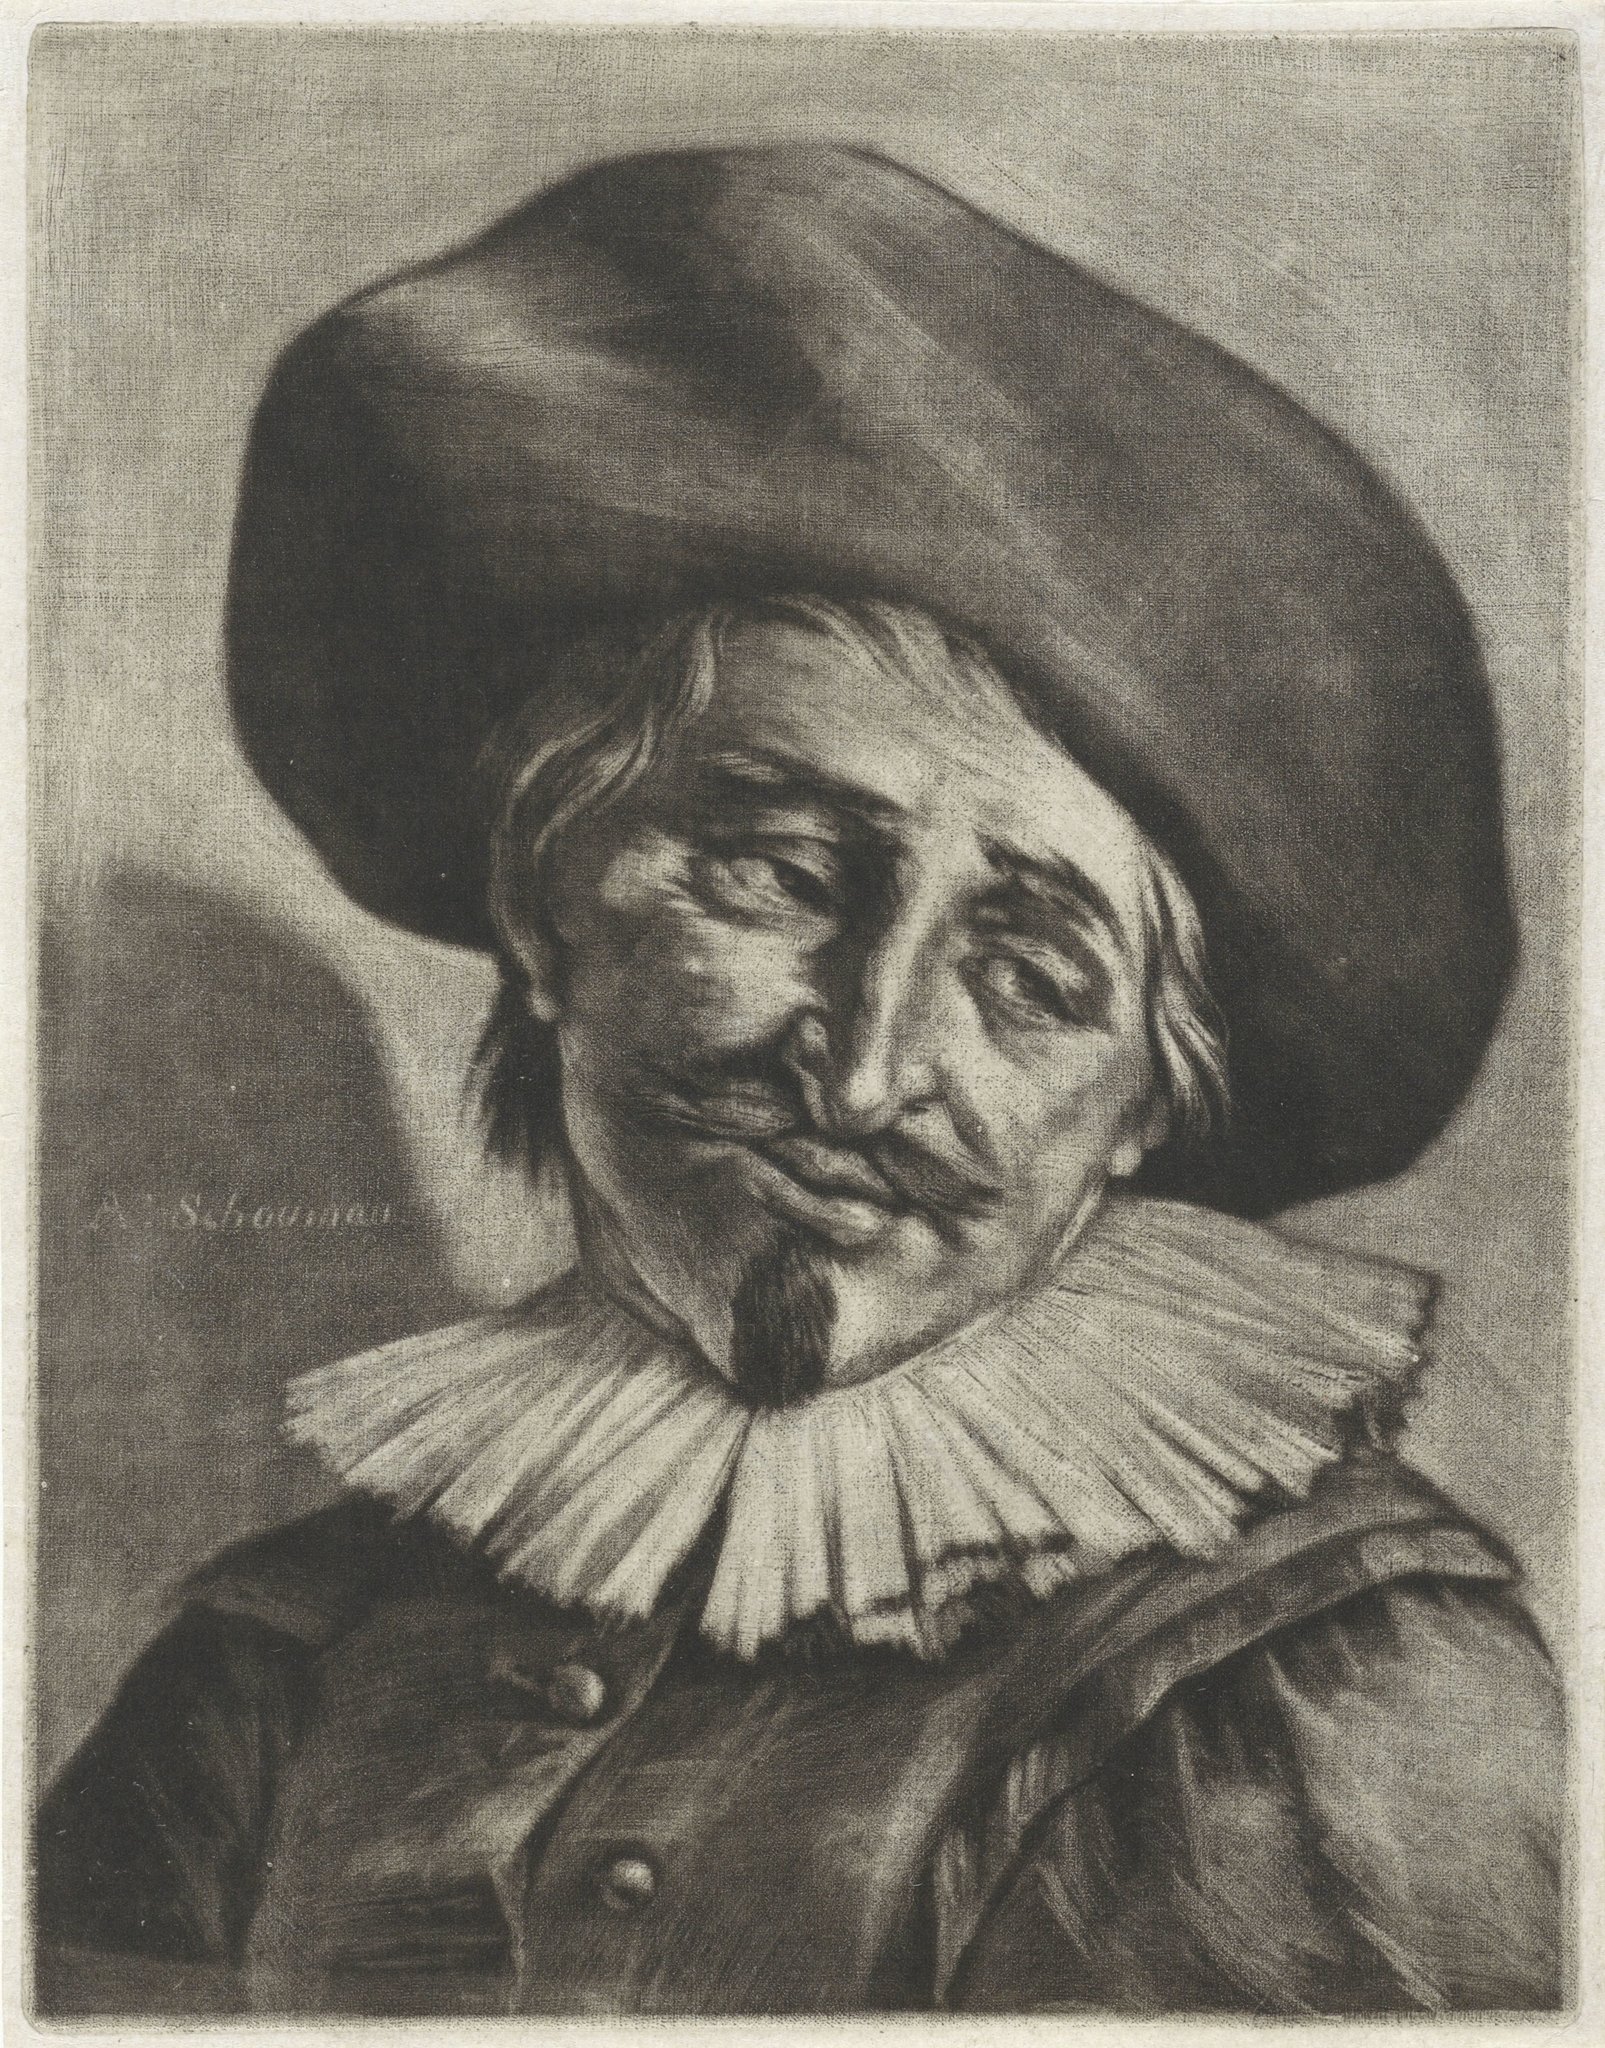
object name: print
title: Droevige man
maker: aert schouman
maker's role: draughtsman, painter, print maker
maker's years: 1710-1792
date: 1720-1792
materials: paper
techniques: mezzotint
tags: head-gear: hat (+ men's clothes), pain, sorrow, sadness; 'dolore', 'dolore di zeusi' (ripa) (+ variant)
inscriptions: collector's mark: Lugt 2228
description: Een man met een hoed en een baardje kijkt bedroefd.